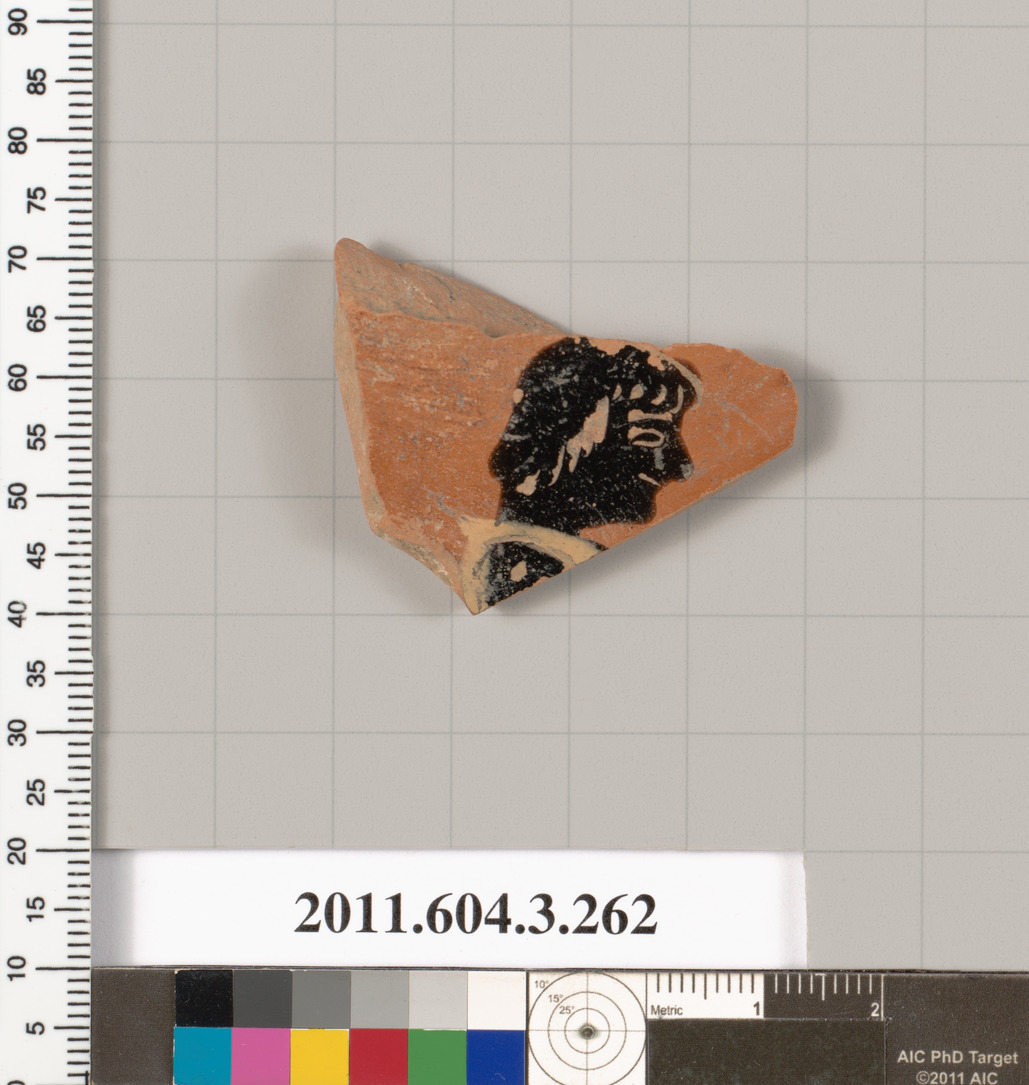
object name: oinochoe fragment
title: Terracotta fragment from an oinochoe (jug)?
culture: greek, attic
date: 490-480 BCE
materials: terracotta